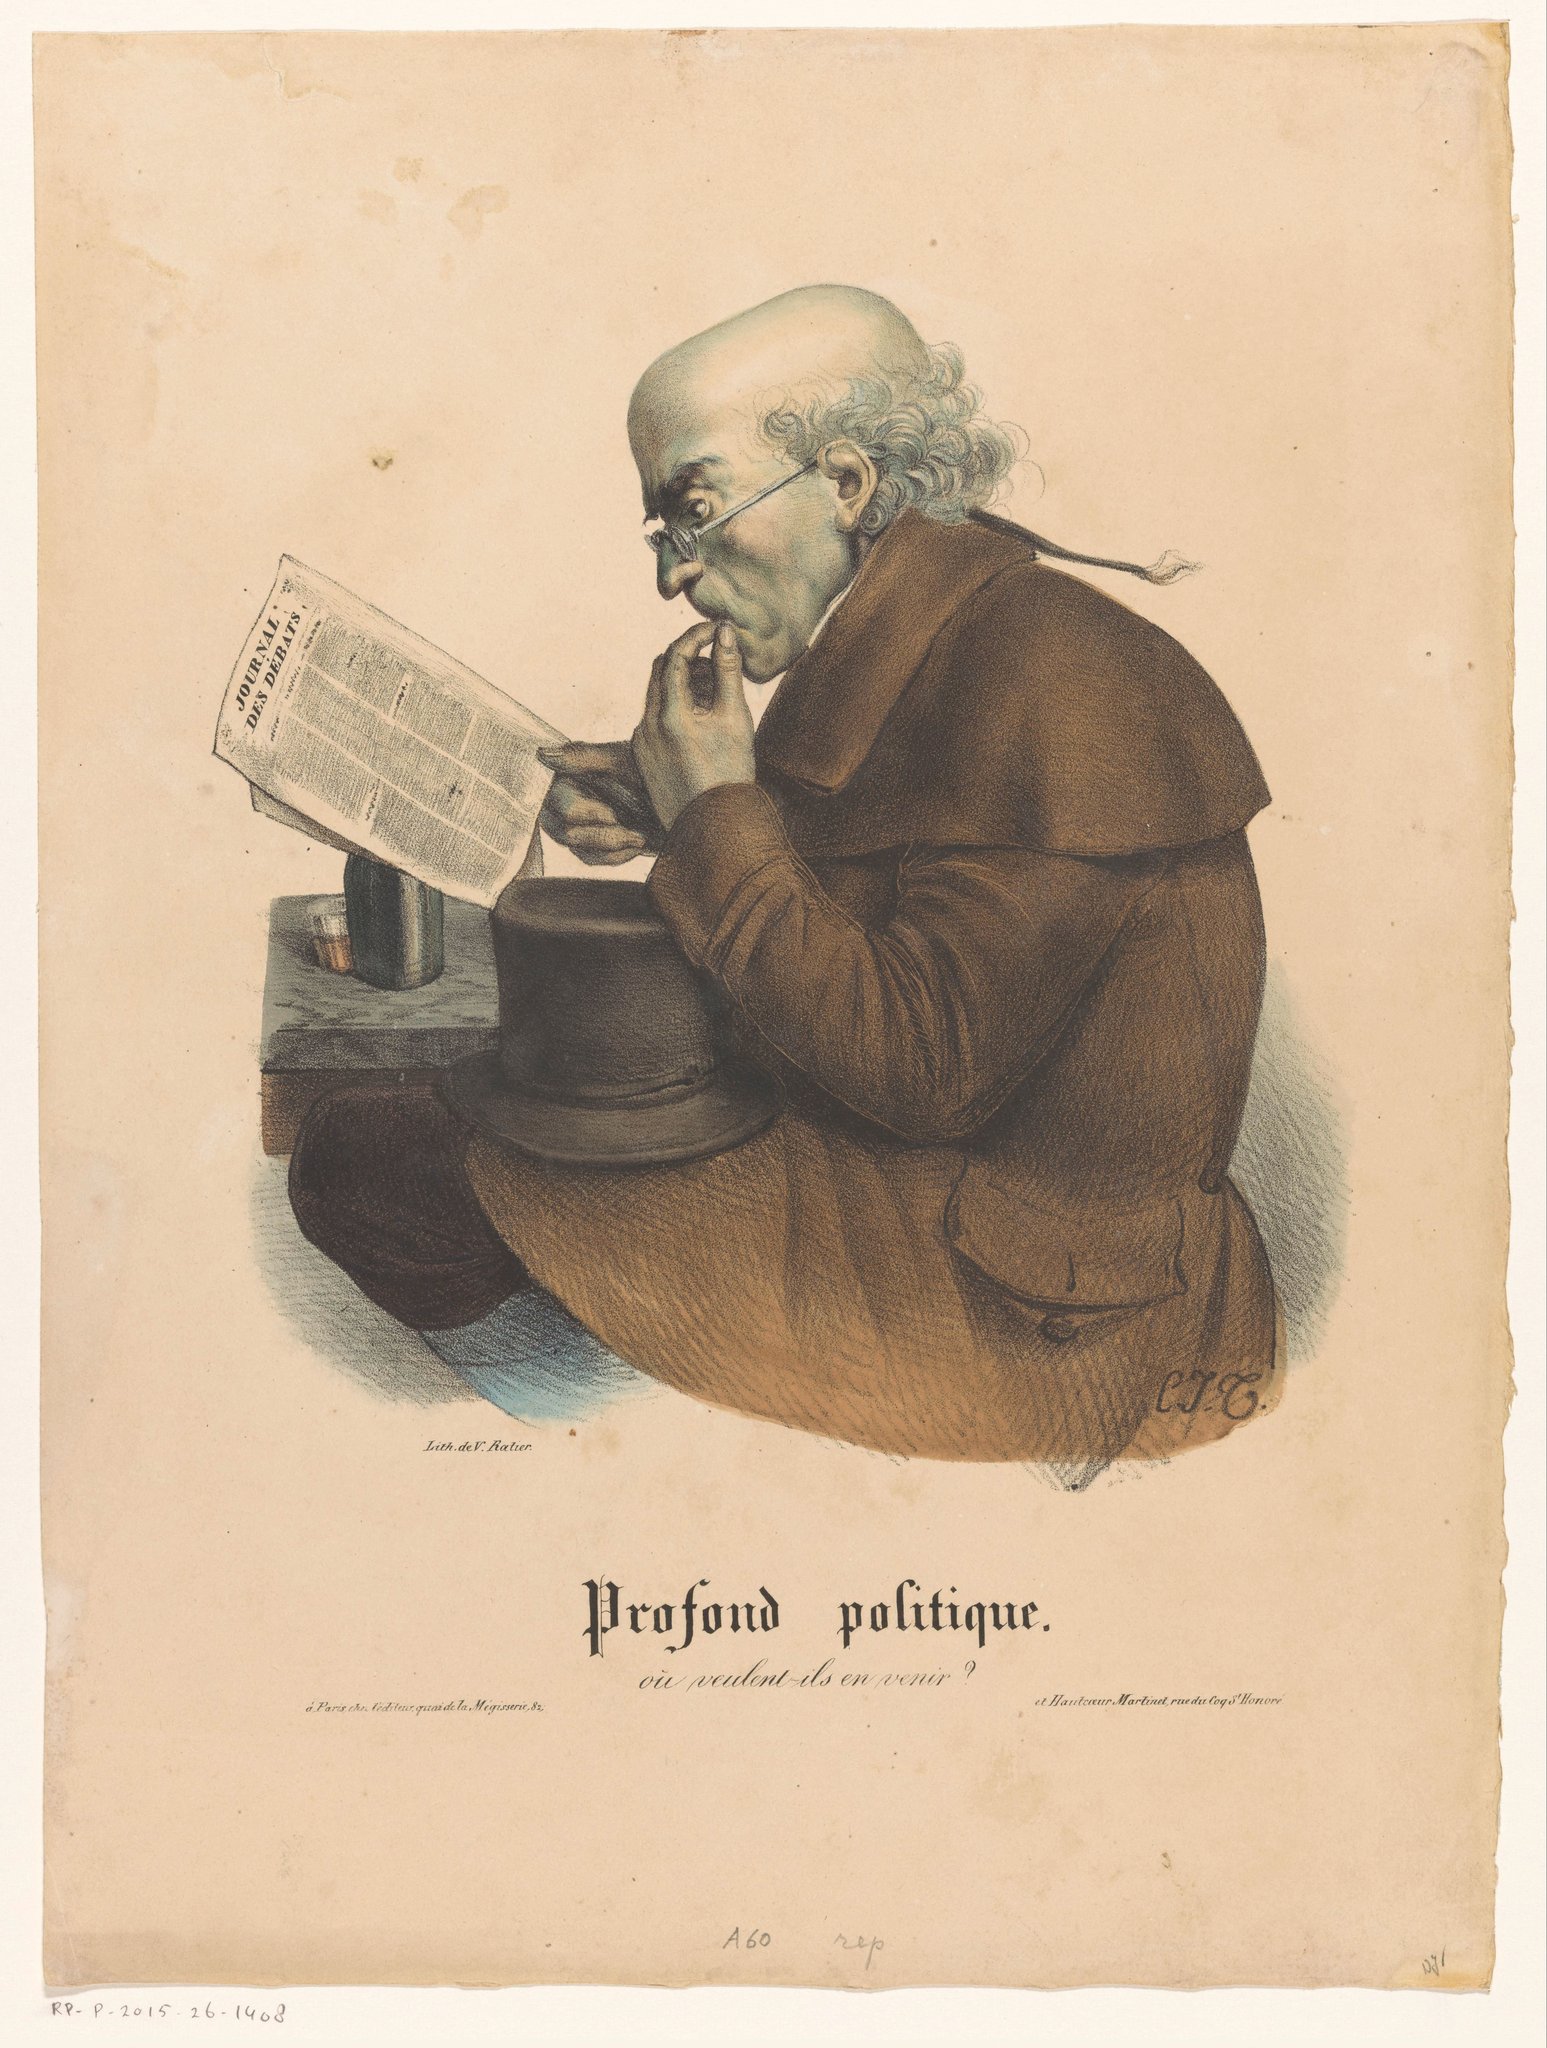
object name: print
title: Man leest een krant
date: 1829-1830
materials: paper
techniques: hand coloring, lithograph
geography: paris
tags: reading, newspaper, news-sheet, political caricatures and satires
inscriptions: collector's mark: Lugt 2228, collector's mark: Lugt 4779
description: Achter een tafel zit een kalende man met een dun staart in zijn nek en zijn hoed op zijn schoot. In zijn rechterhand houdt hij een aflevering van 'Journal des débats'. Hij heeft een gefronste blik en met zijn linkerhand raakt hij zijn mond aan.